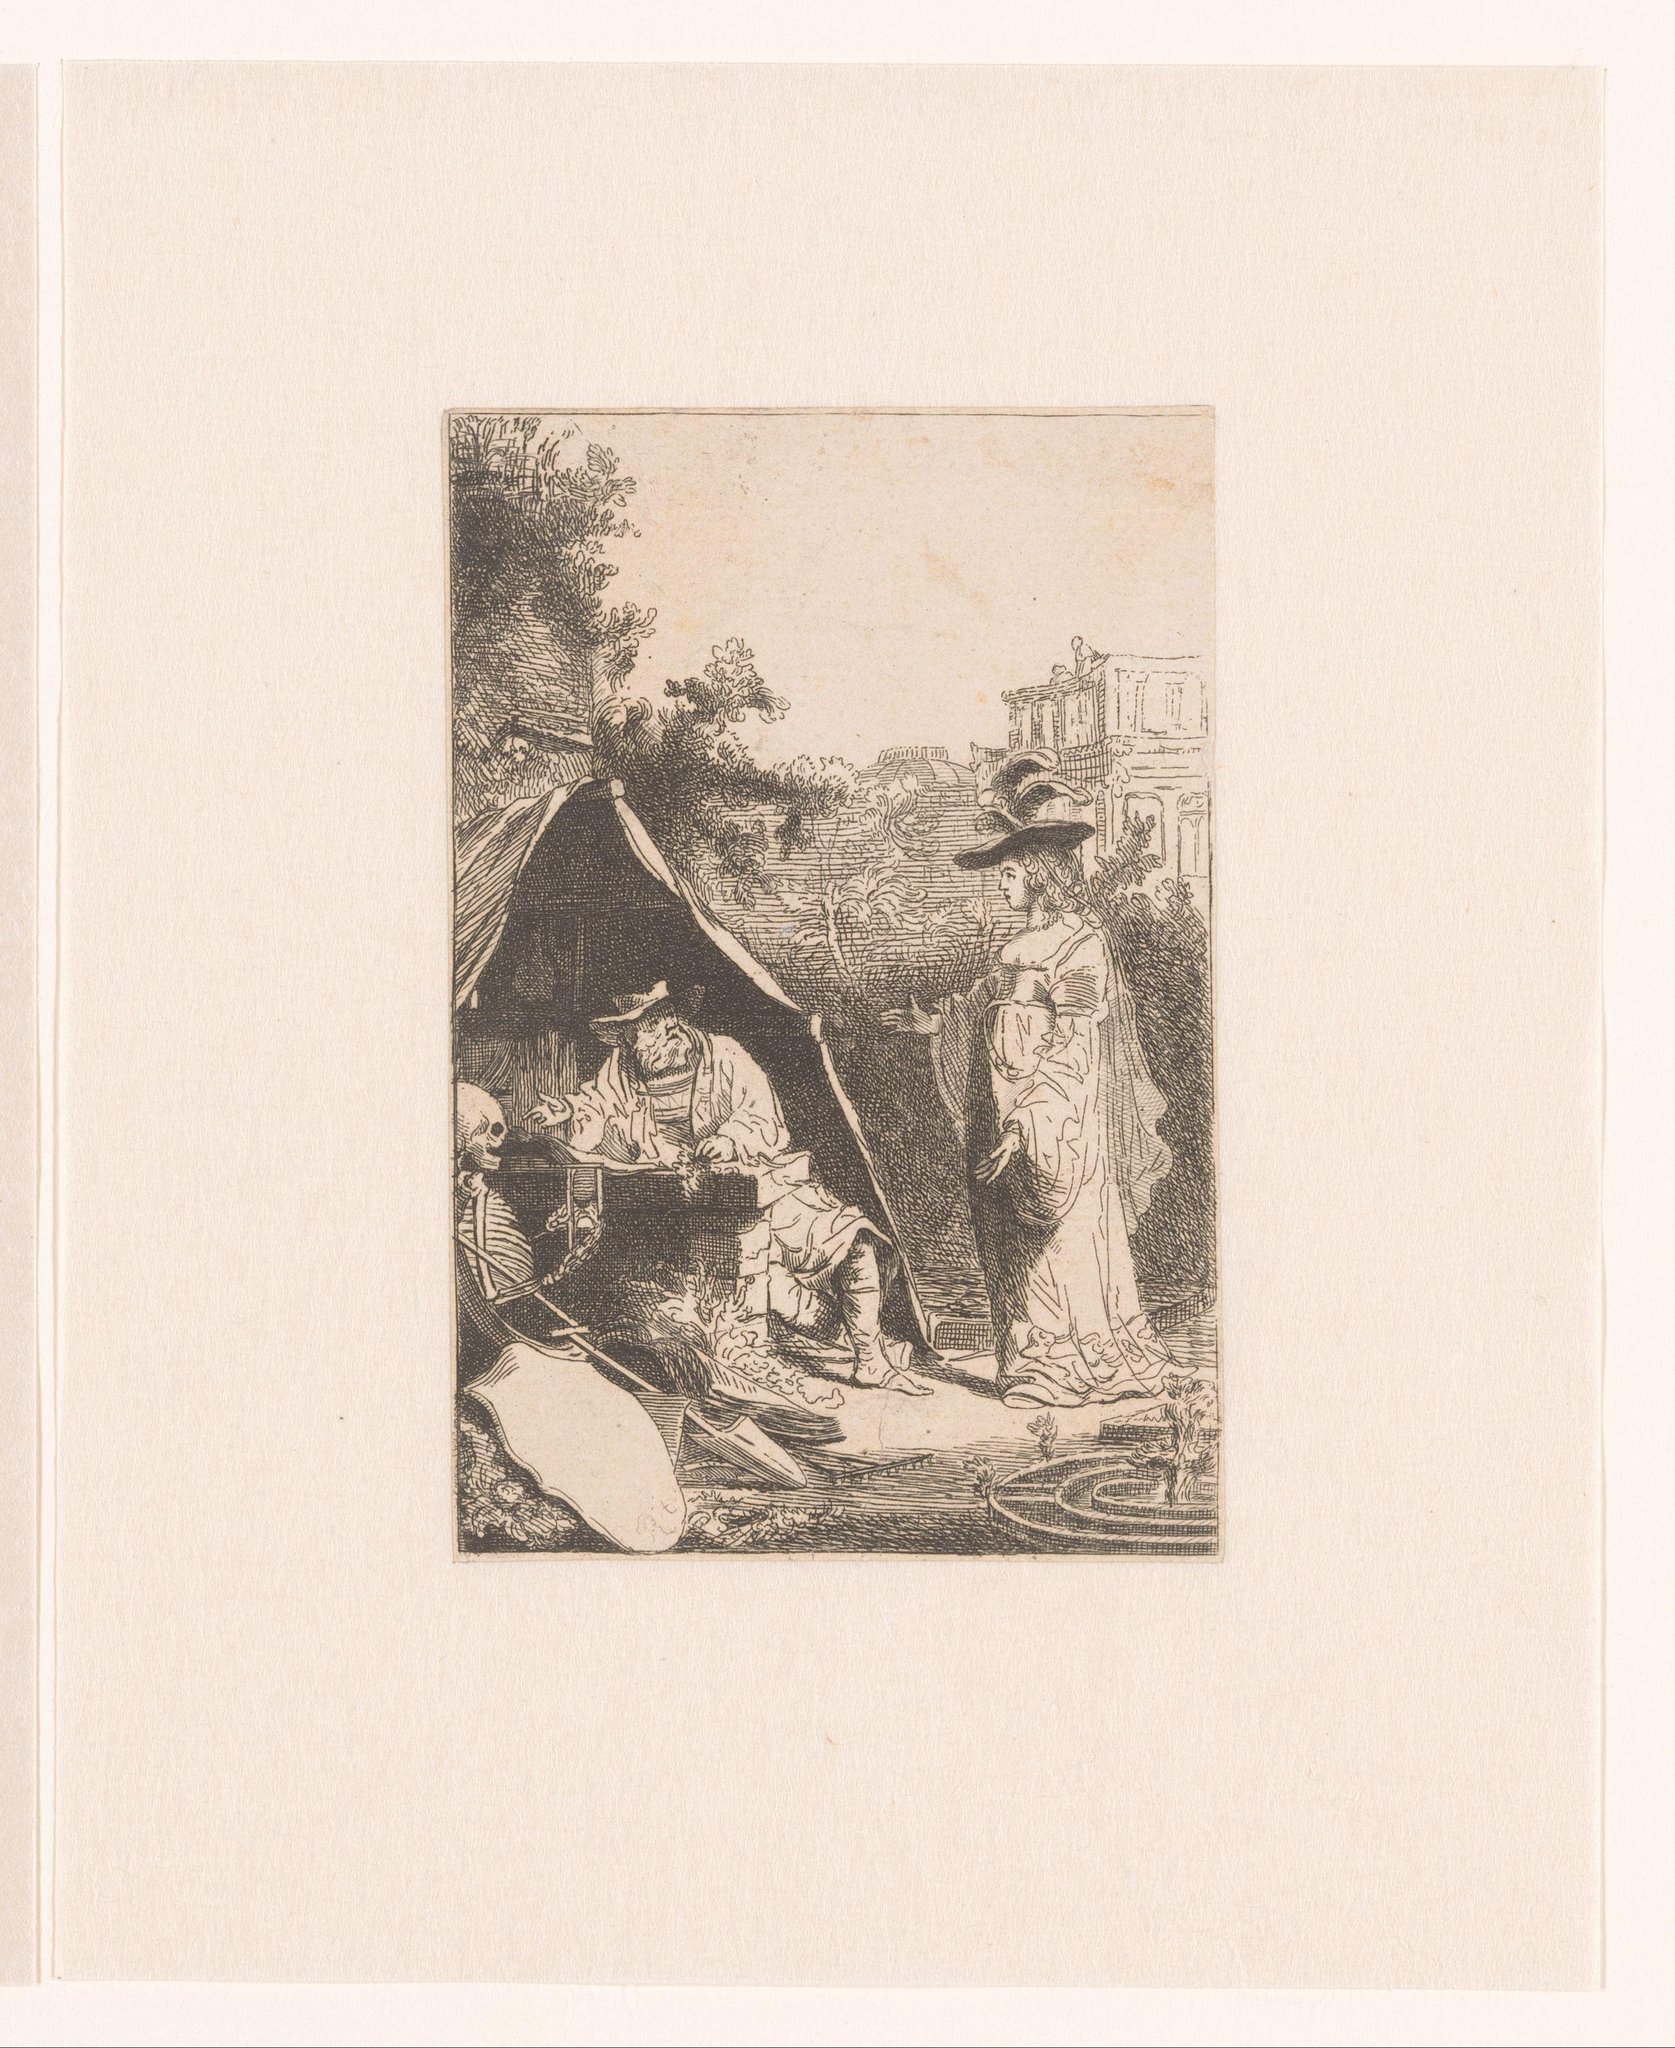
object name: print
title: Jonge vrouw en oude man met De Dood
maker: james hazard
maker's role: print maker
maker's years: 1748-1787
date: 1758-1787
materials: paper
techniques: etching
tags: dance of death; death together with one or more human beings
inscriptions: collector's mark: Lugt 2228, collector's mark: Lugt 2760